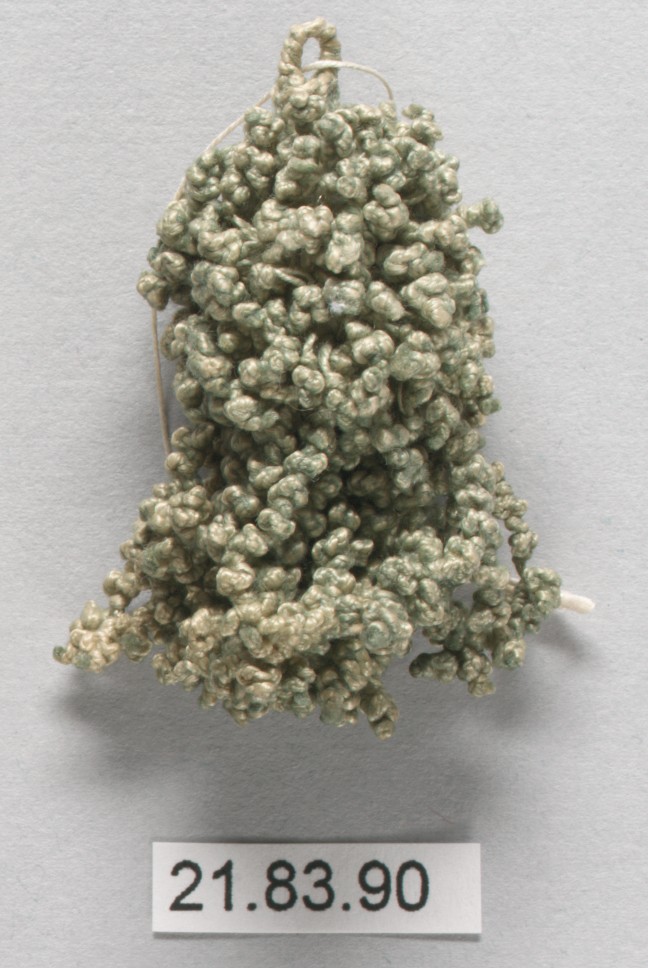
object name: tassel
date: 1601-1700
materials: linen